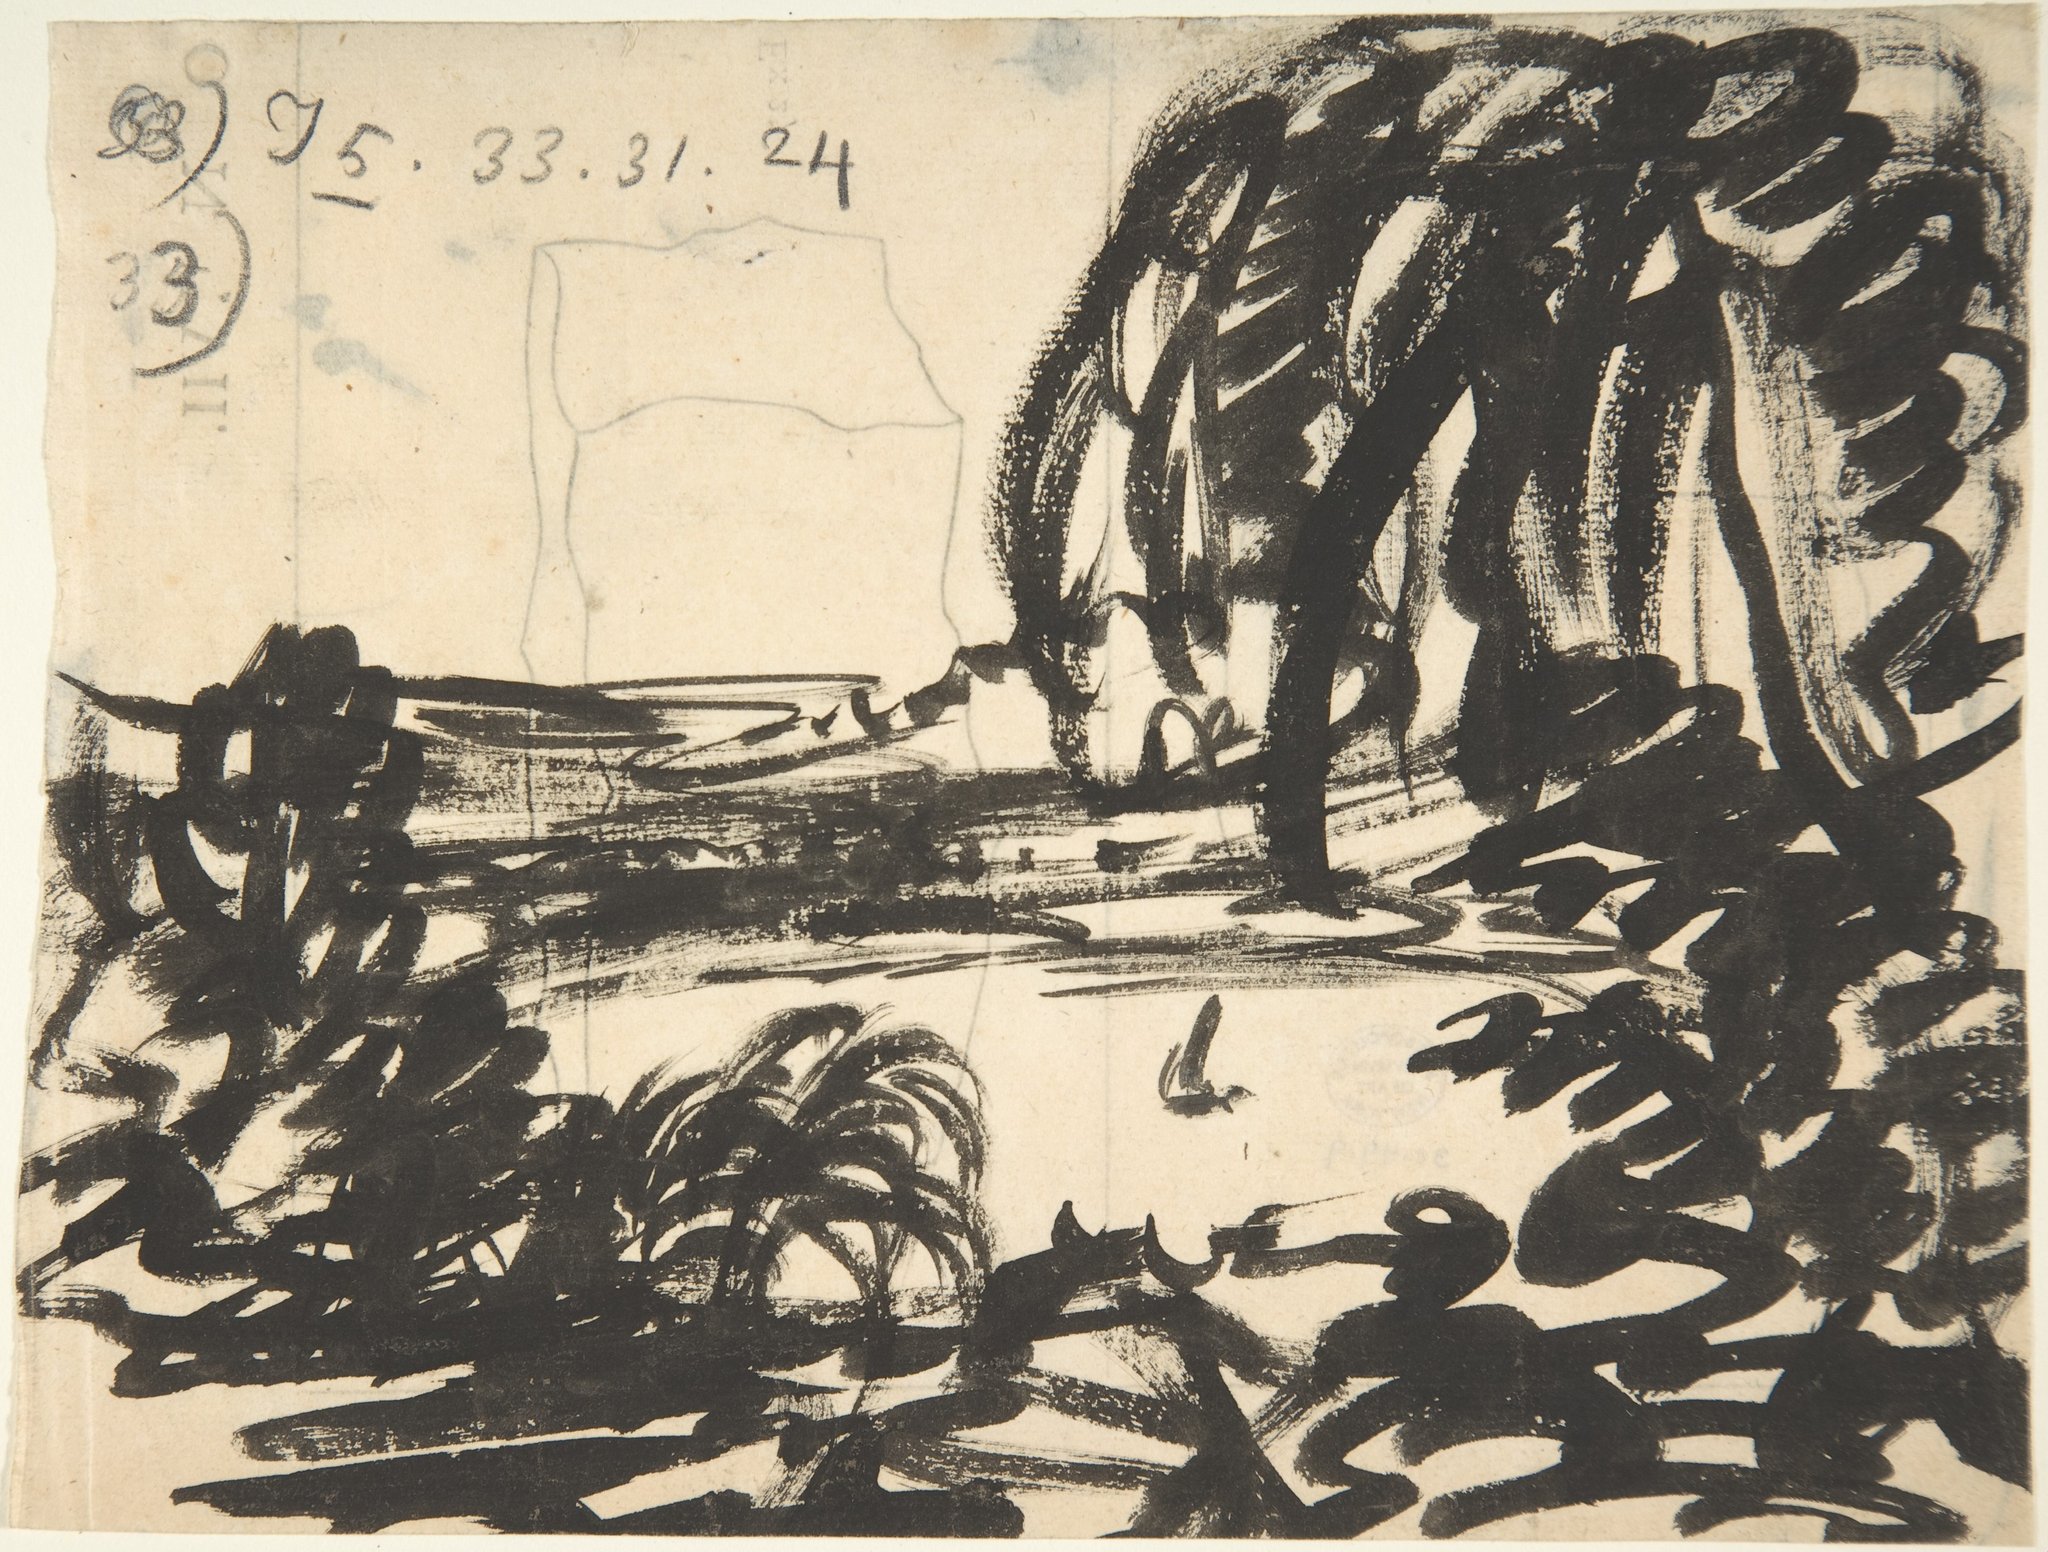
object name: drawing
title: A blot-lake with boat, surrounded by trees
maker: alexander cozens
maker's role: artist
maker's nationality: british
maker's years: 1717-1786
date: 1750-1786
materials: graphite, ink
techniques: brush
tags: abstraction